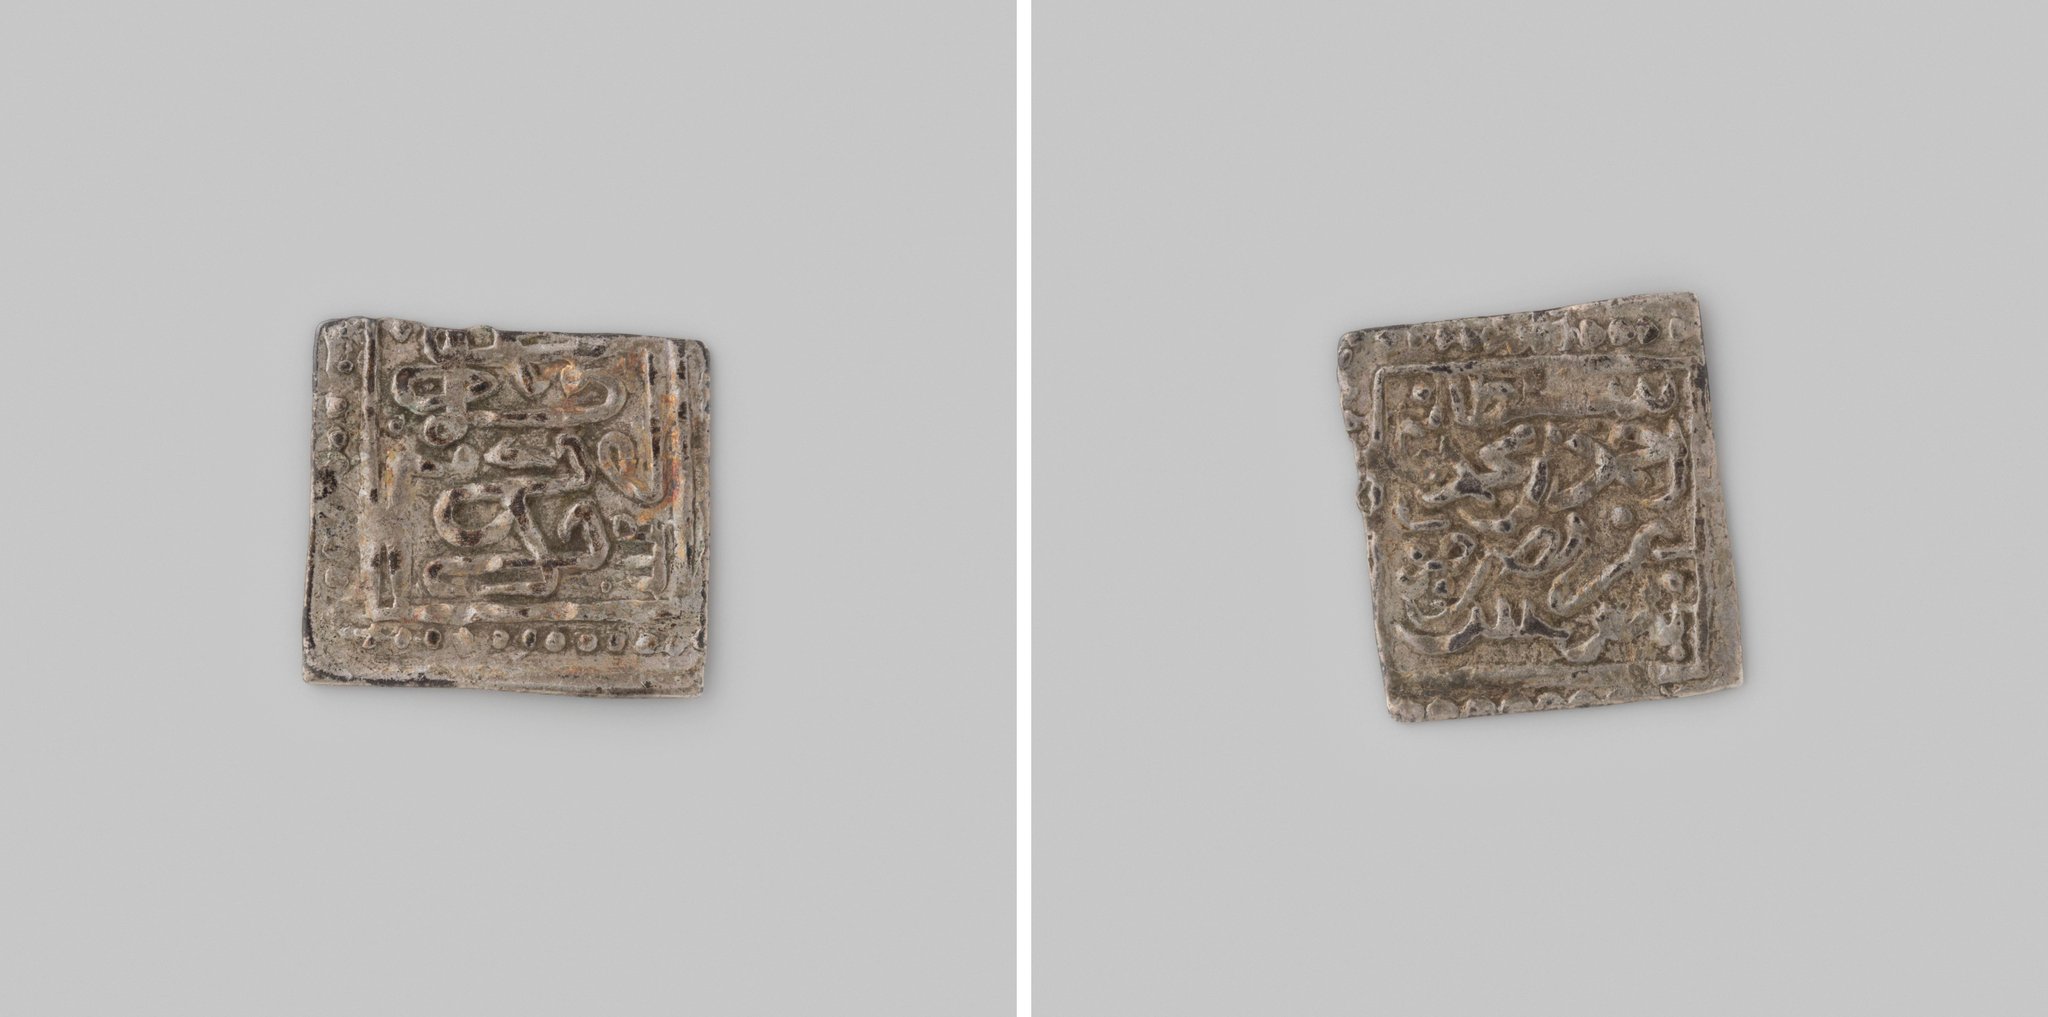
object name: coin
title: Para uit Tunesië van Sultan Ahmed VI Mohammed Khan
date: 1750-1850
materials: silver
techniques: striking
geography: tunisia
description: Zilveren rechthoekige munt. Voorzijde: vierregelig opschrift in Arabische letters. Keerzijde: vijfregelig opschrift in Arabische letters.